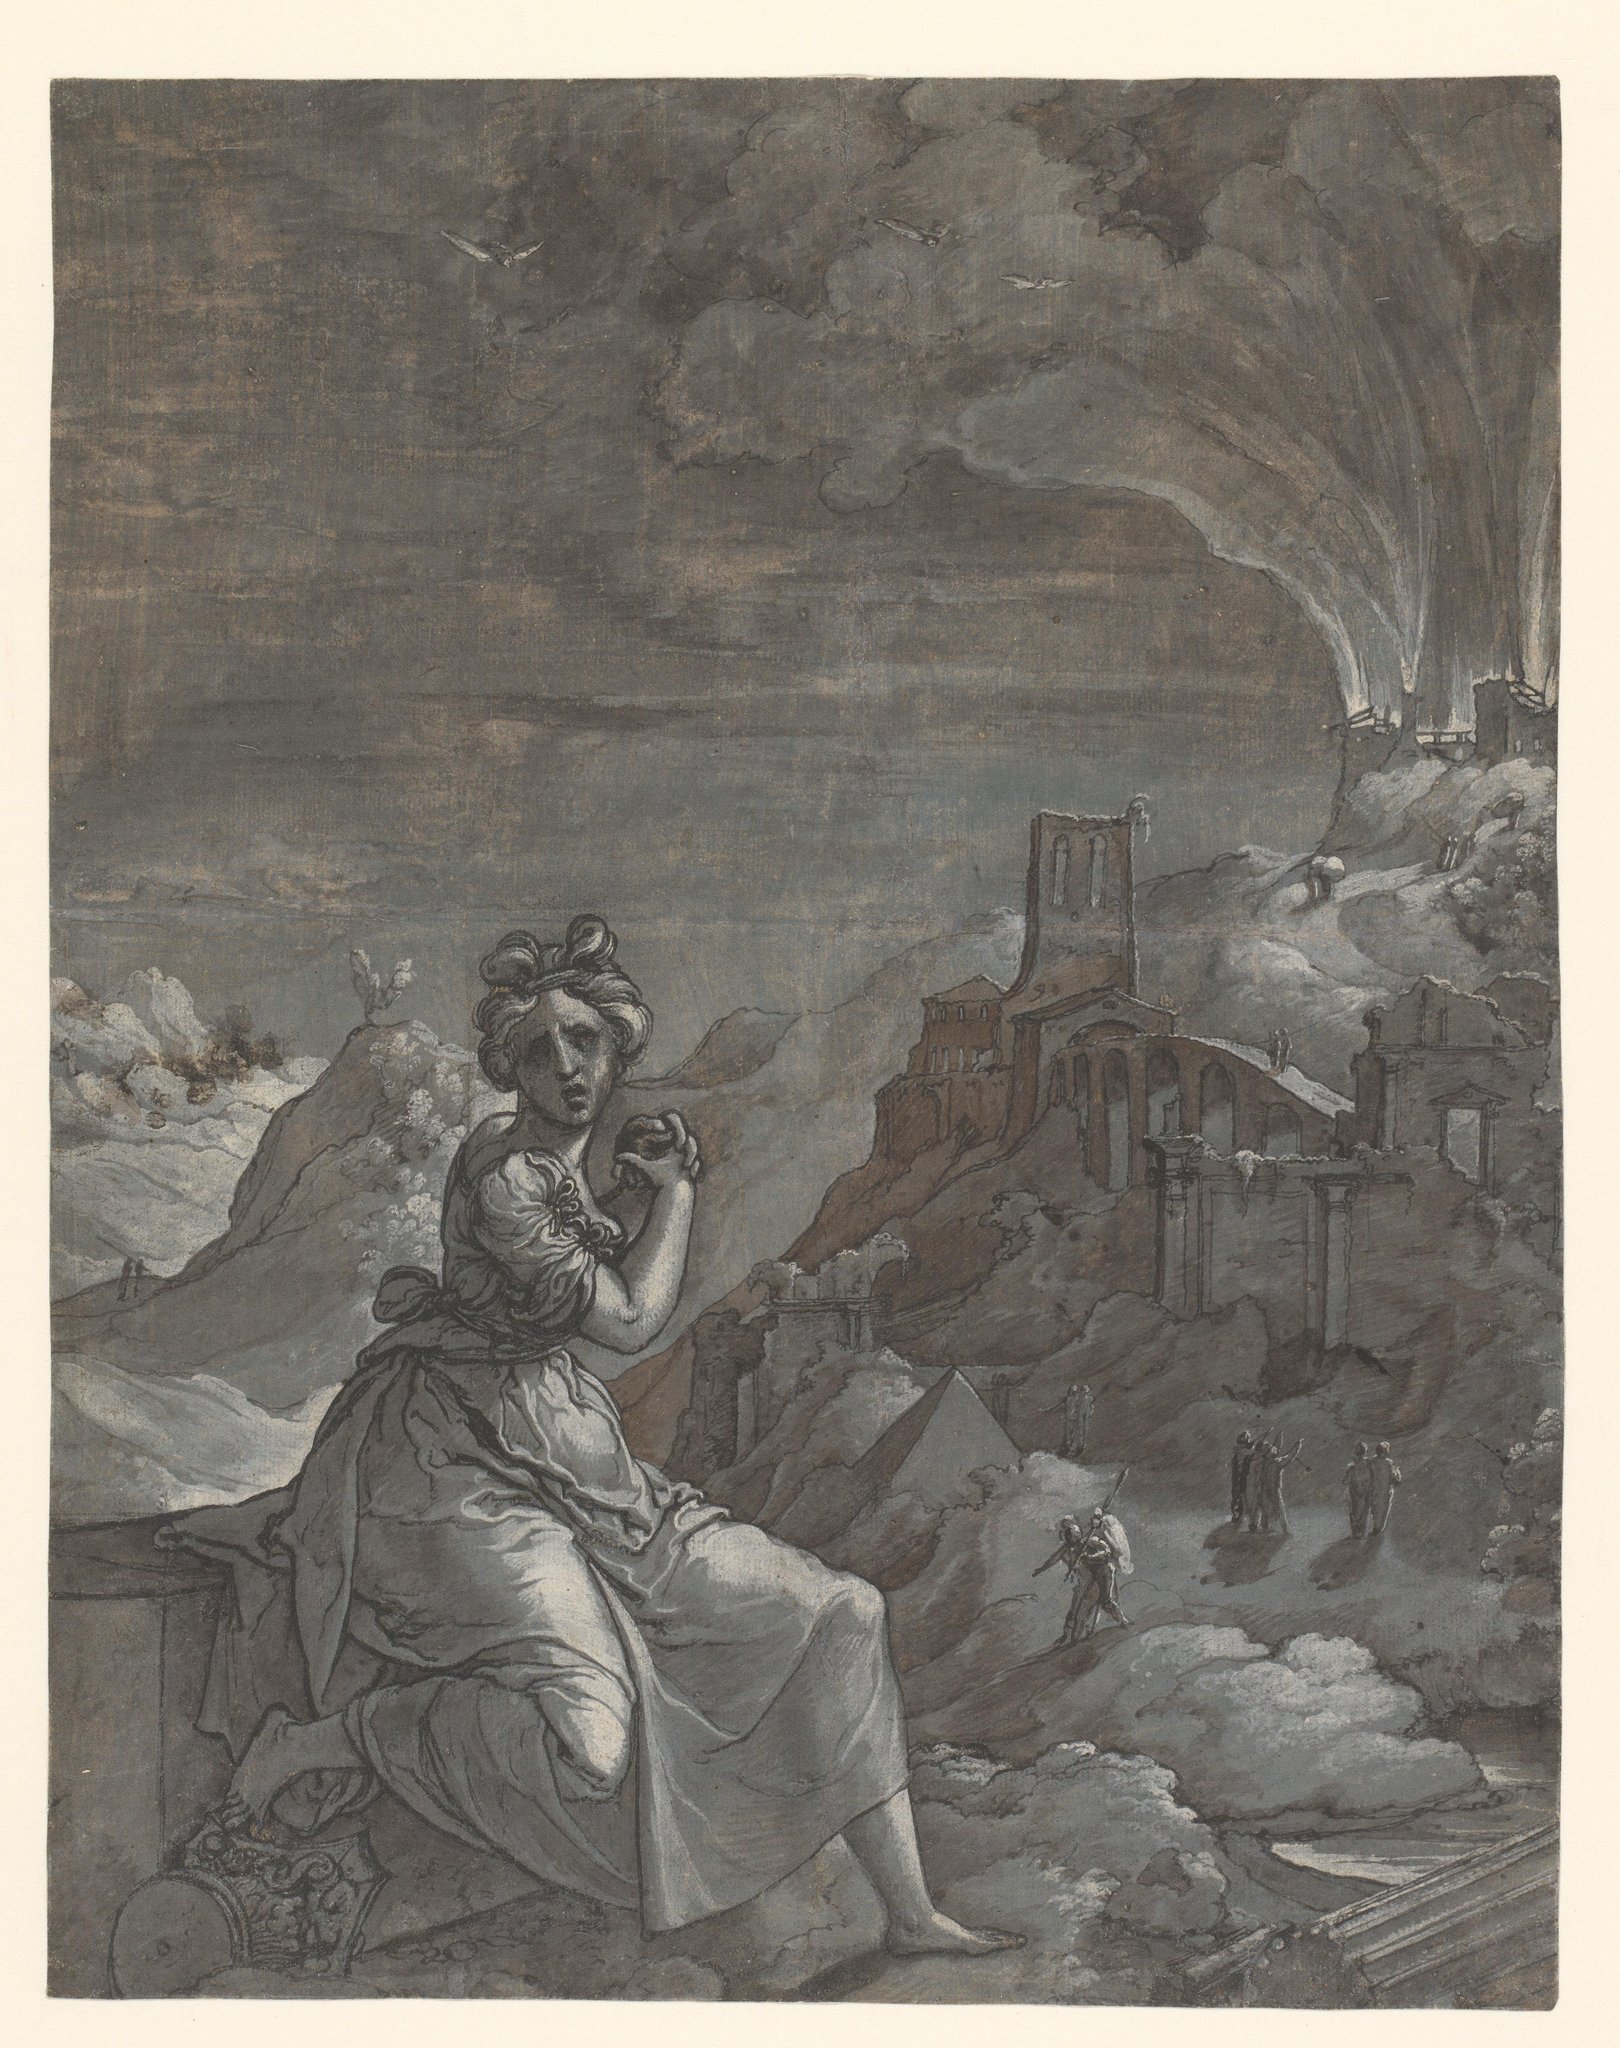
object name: drawing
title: Cassandra treurt over de verwoesting van Troje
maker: jan swart van groningen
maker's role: draughtsman, painter, print maker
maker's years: 1500-1562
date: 1550-1555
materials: ink, paint, paper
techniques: brush, pen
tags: non-aggressive, friendly or neutral activities and relationships of cassandra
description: Cassandra zit op de voorgrond, haar hoofd gewend naar de beschouwer. Zij treurt over de verwoesting van de stad Troje die op de achtergrond in vlammen opgaat. Rechtsonder een gebroken zuil.